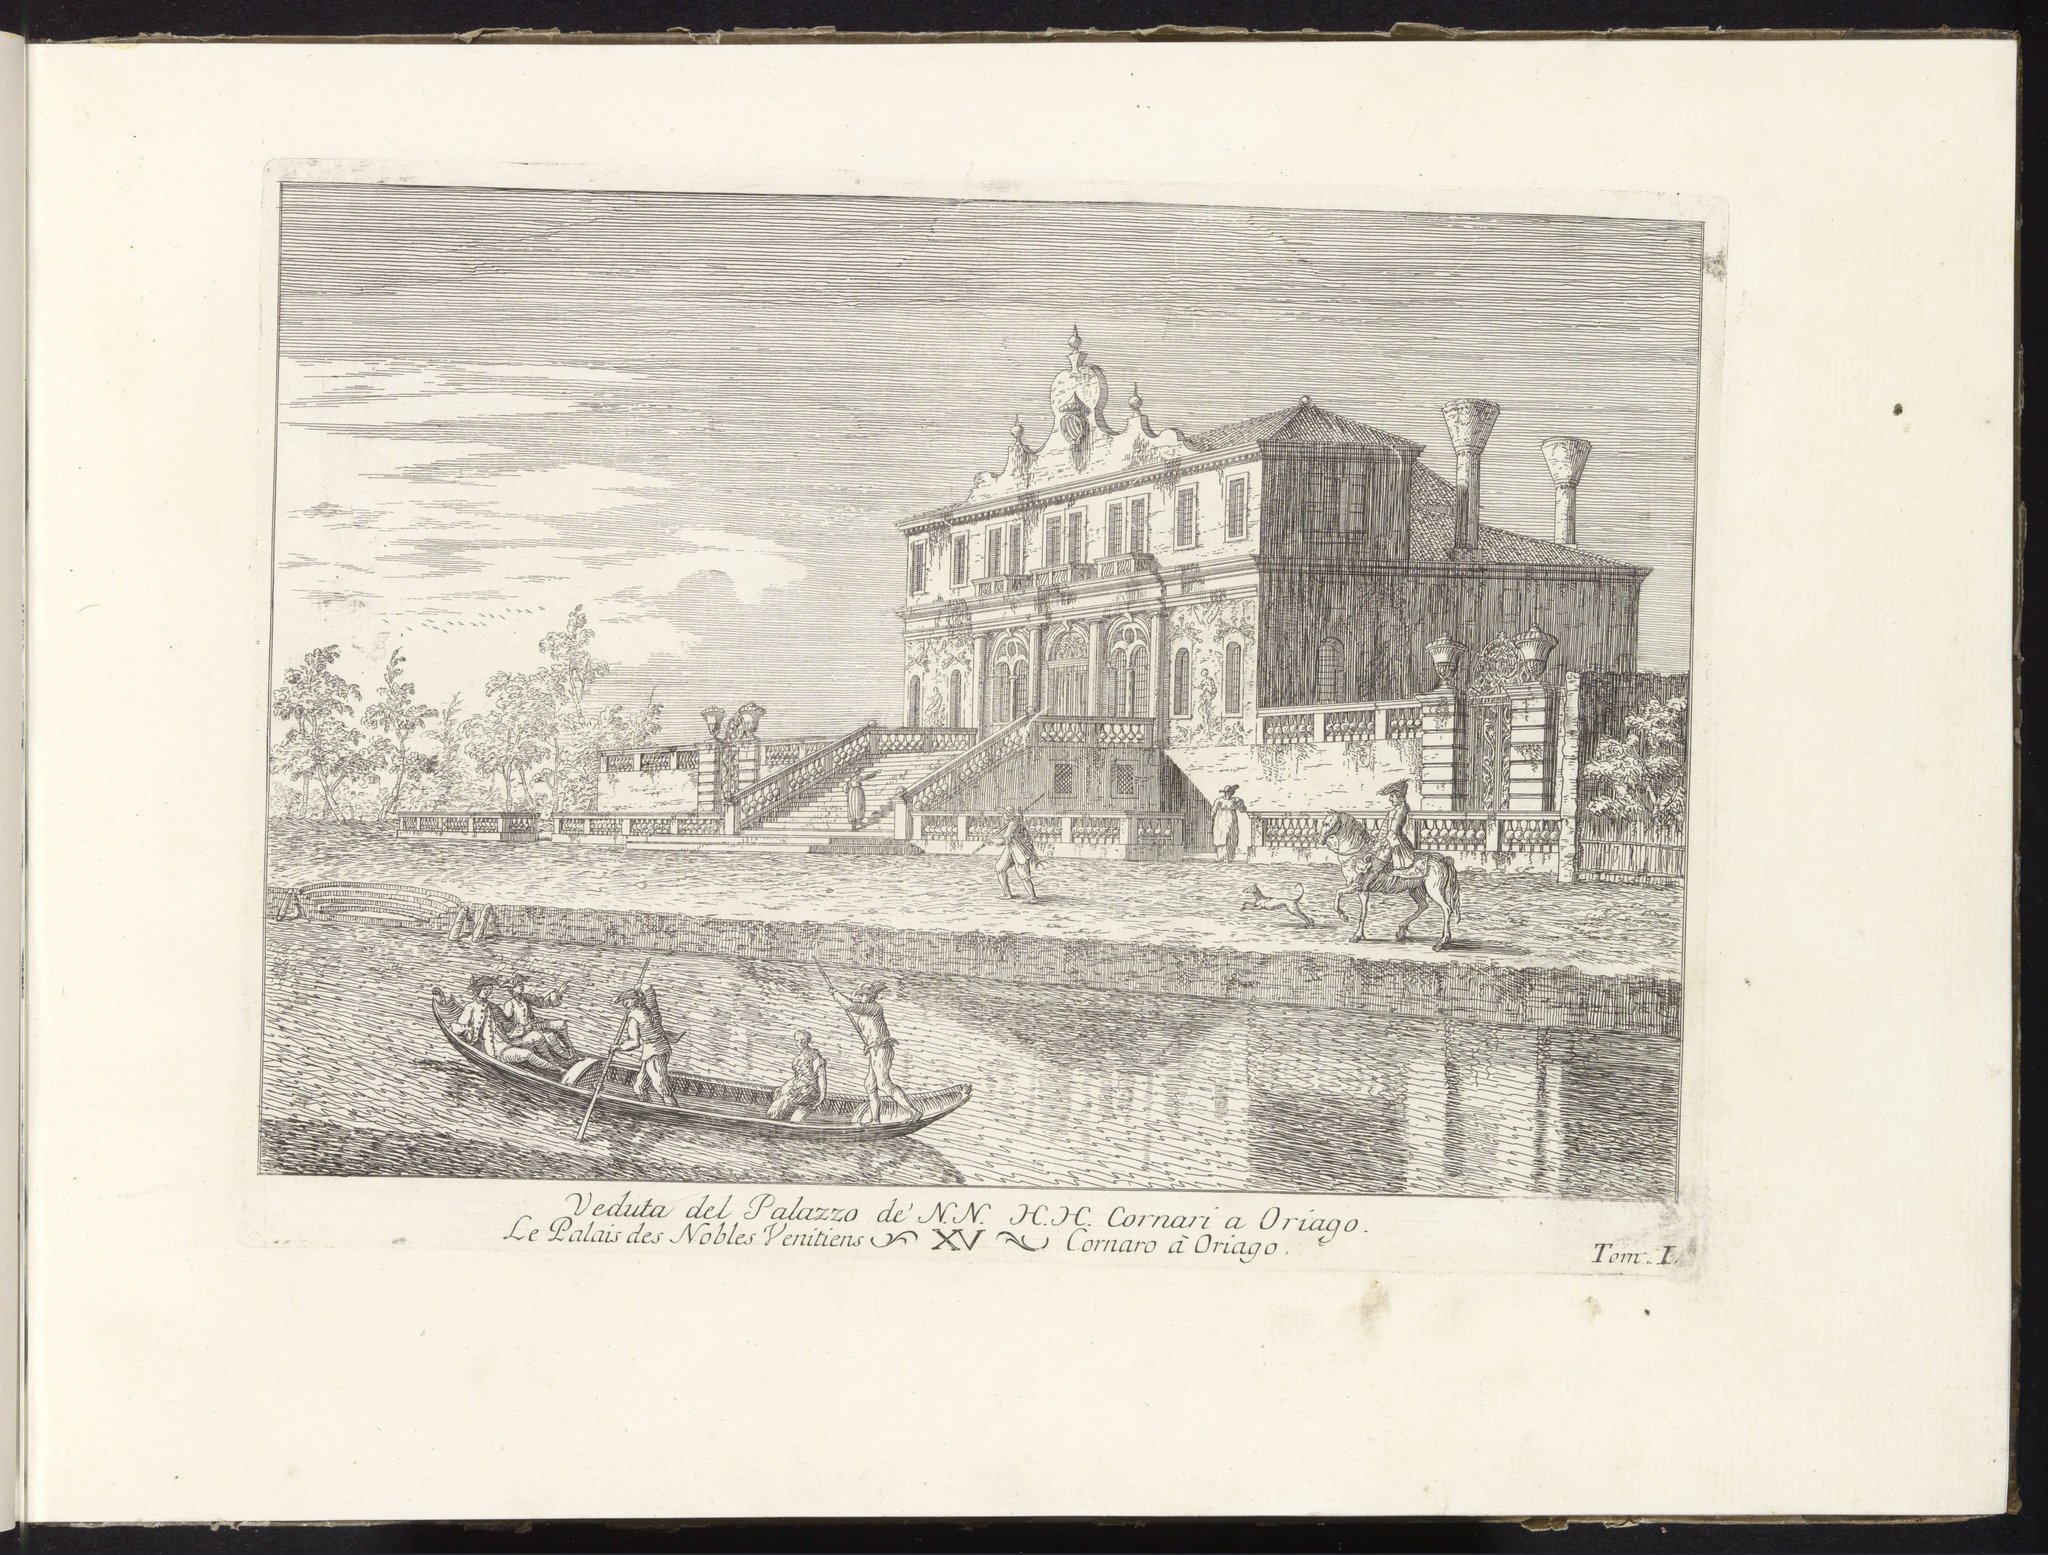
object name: print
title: Le delicie della Brenta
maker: giovanni francesco costa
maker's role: draughtsman, painter, print maker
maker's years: -1773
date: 1750-1760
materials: paper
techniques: etching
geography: venice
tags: river, hôtel, i.e. small palace in city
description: Gezicht op Palazzo de' N. N. H. H. Cornari aan de rivier de Brenta te Oriago. Over het water vaart een gondel met vijf figuren. Genummerd midden onder: XV en rechtsonder: Tom: I. Deze prent maakt deel uit van een album.